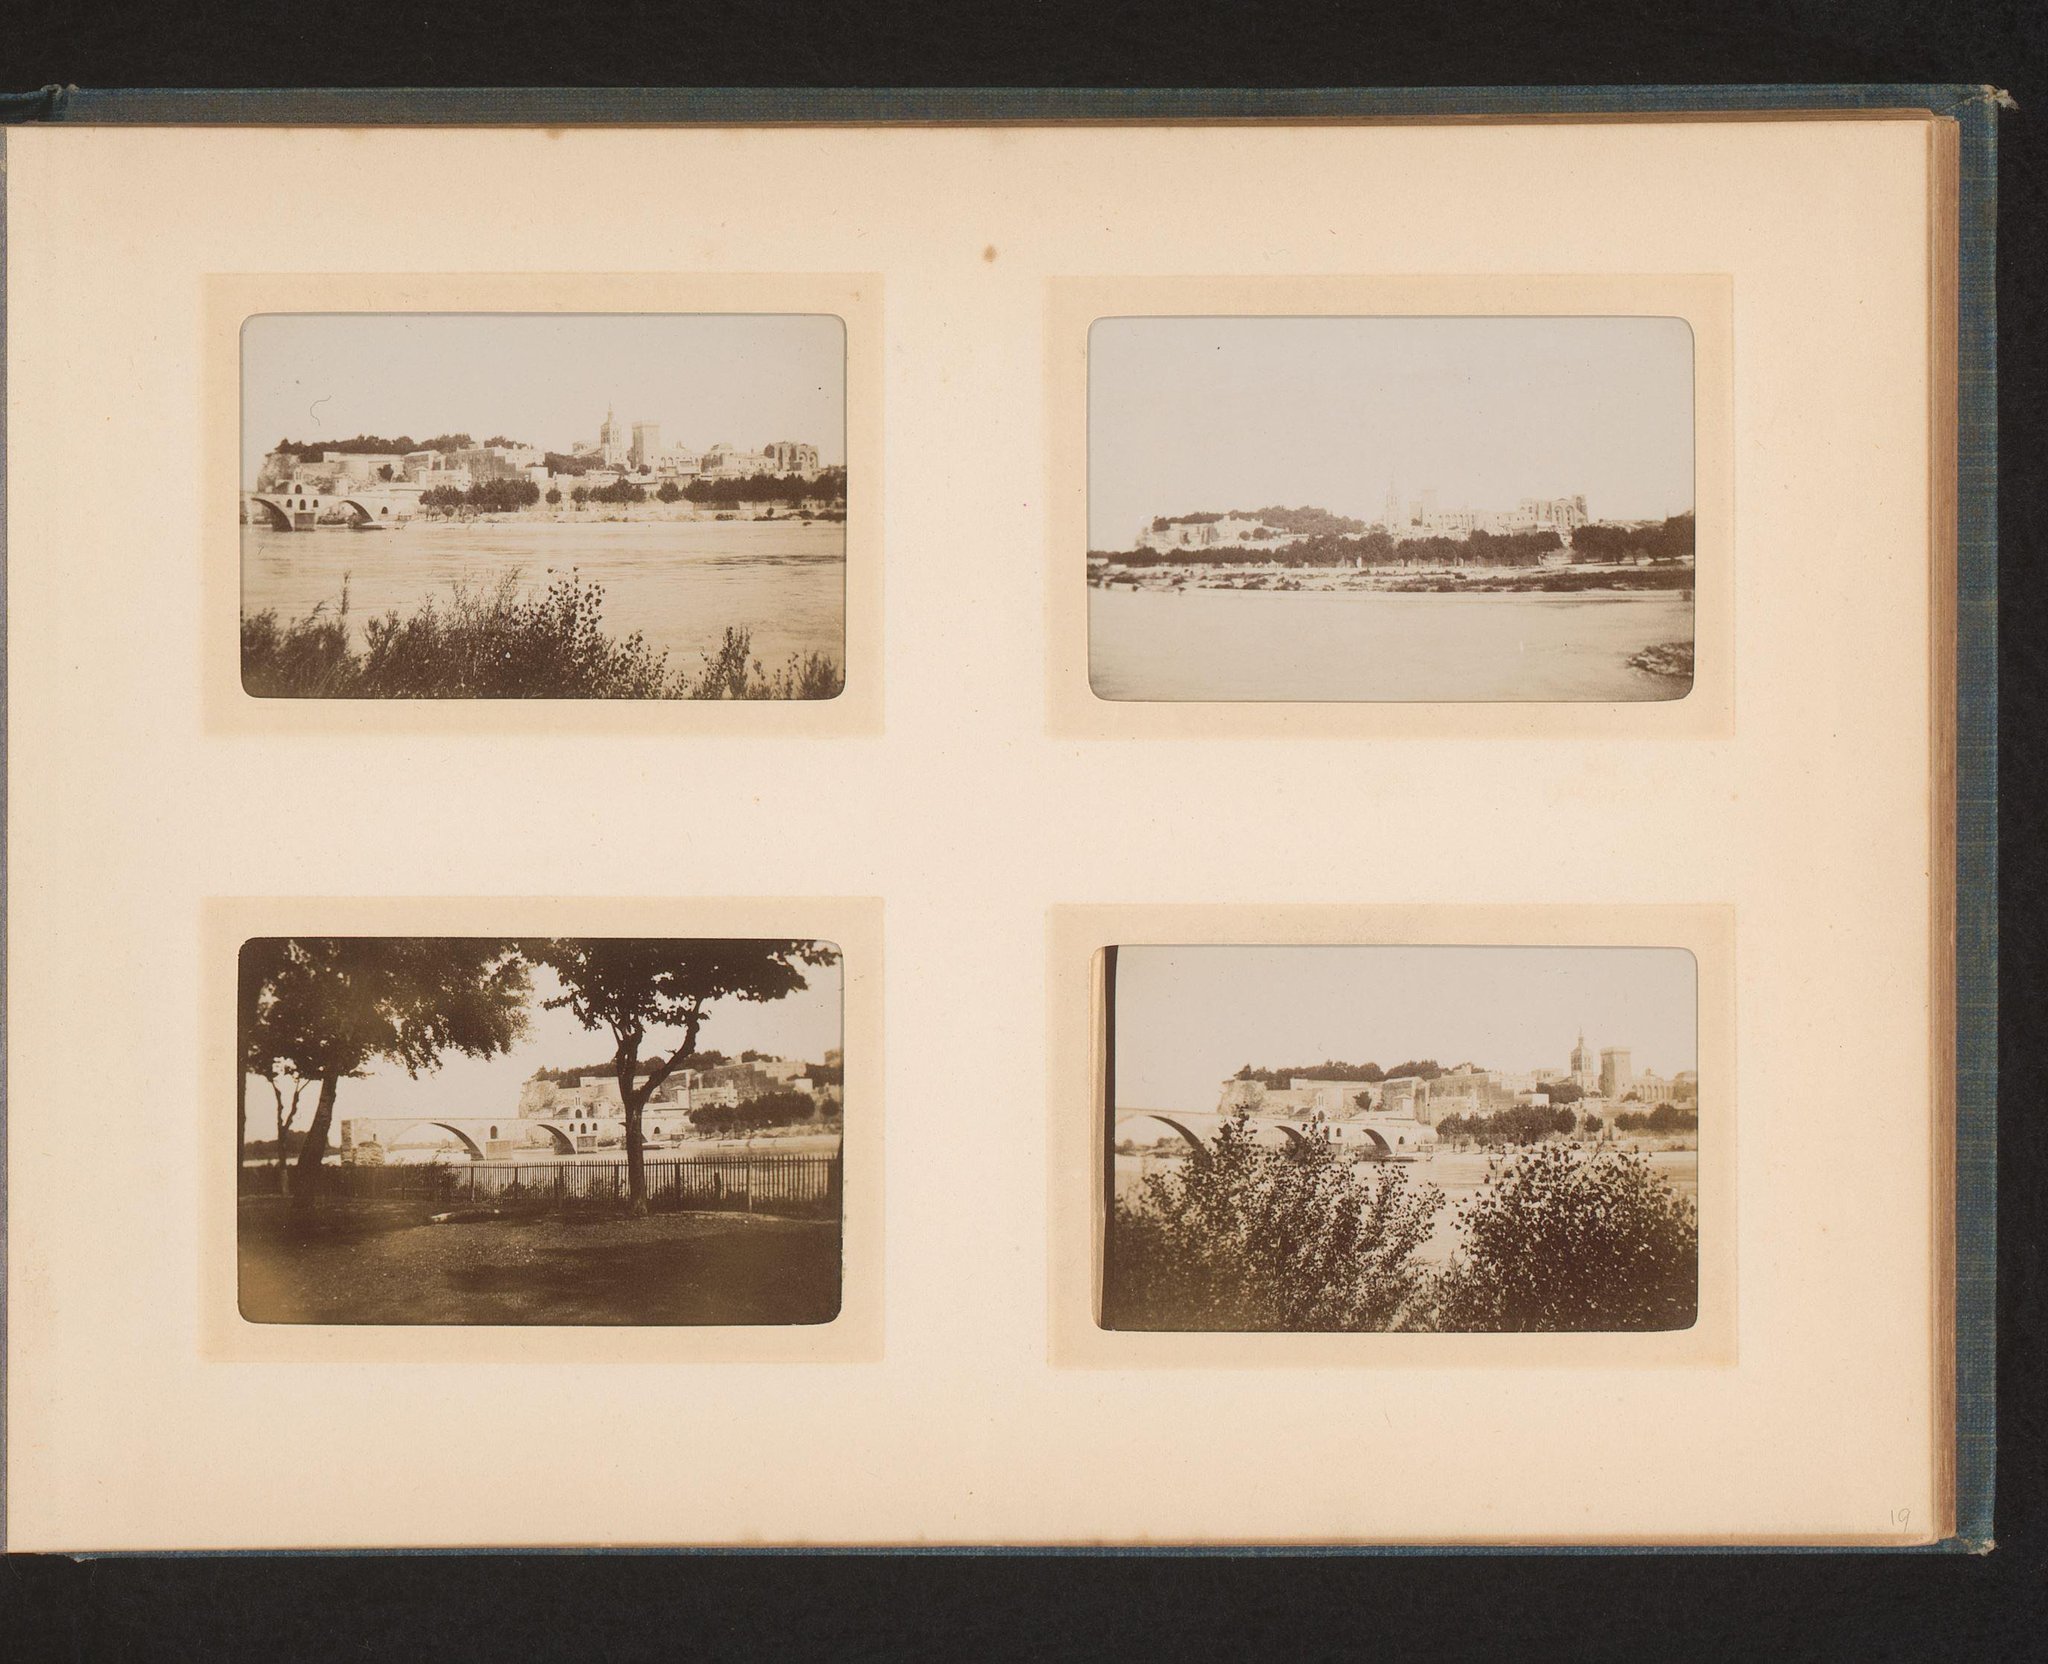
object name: album leaf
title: Vier stadsgezichten met een rivier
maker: Anonymous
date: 1900-1915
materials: paper, photographic support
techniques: gelatin silver print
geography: france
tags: city-view in general; 'veduta', river, travelling; tourism, france